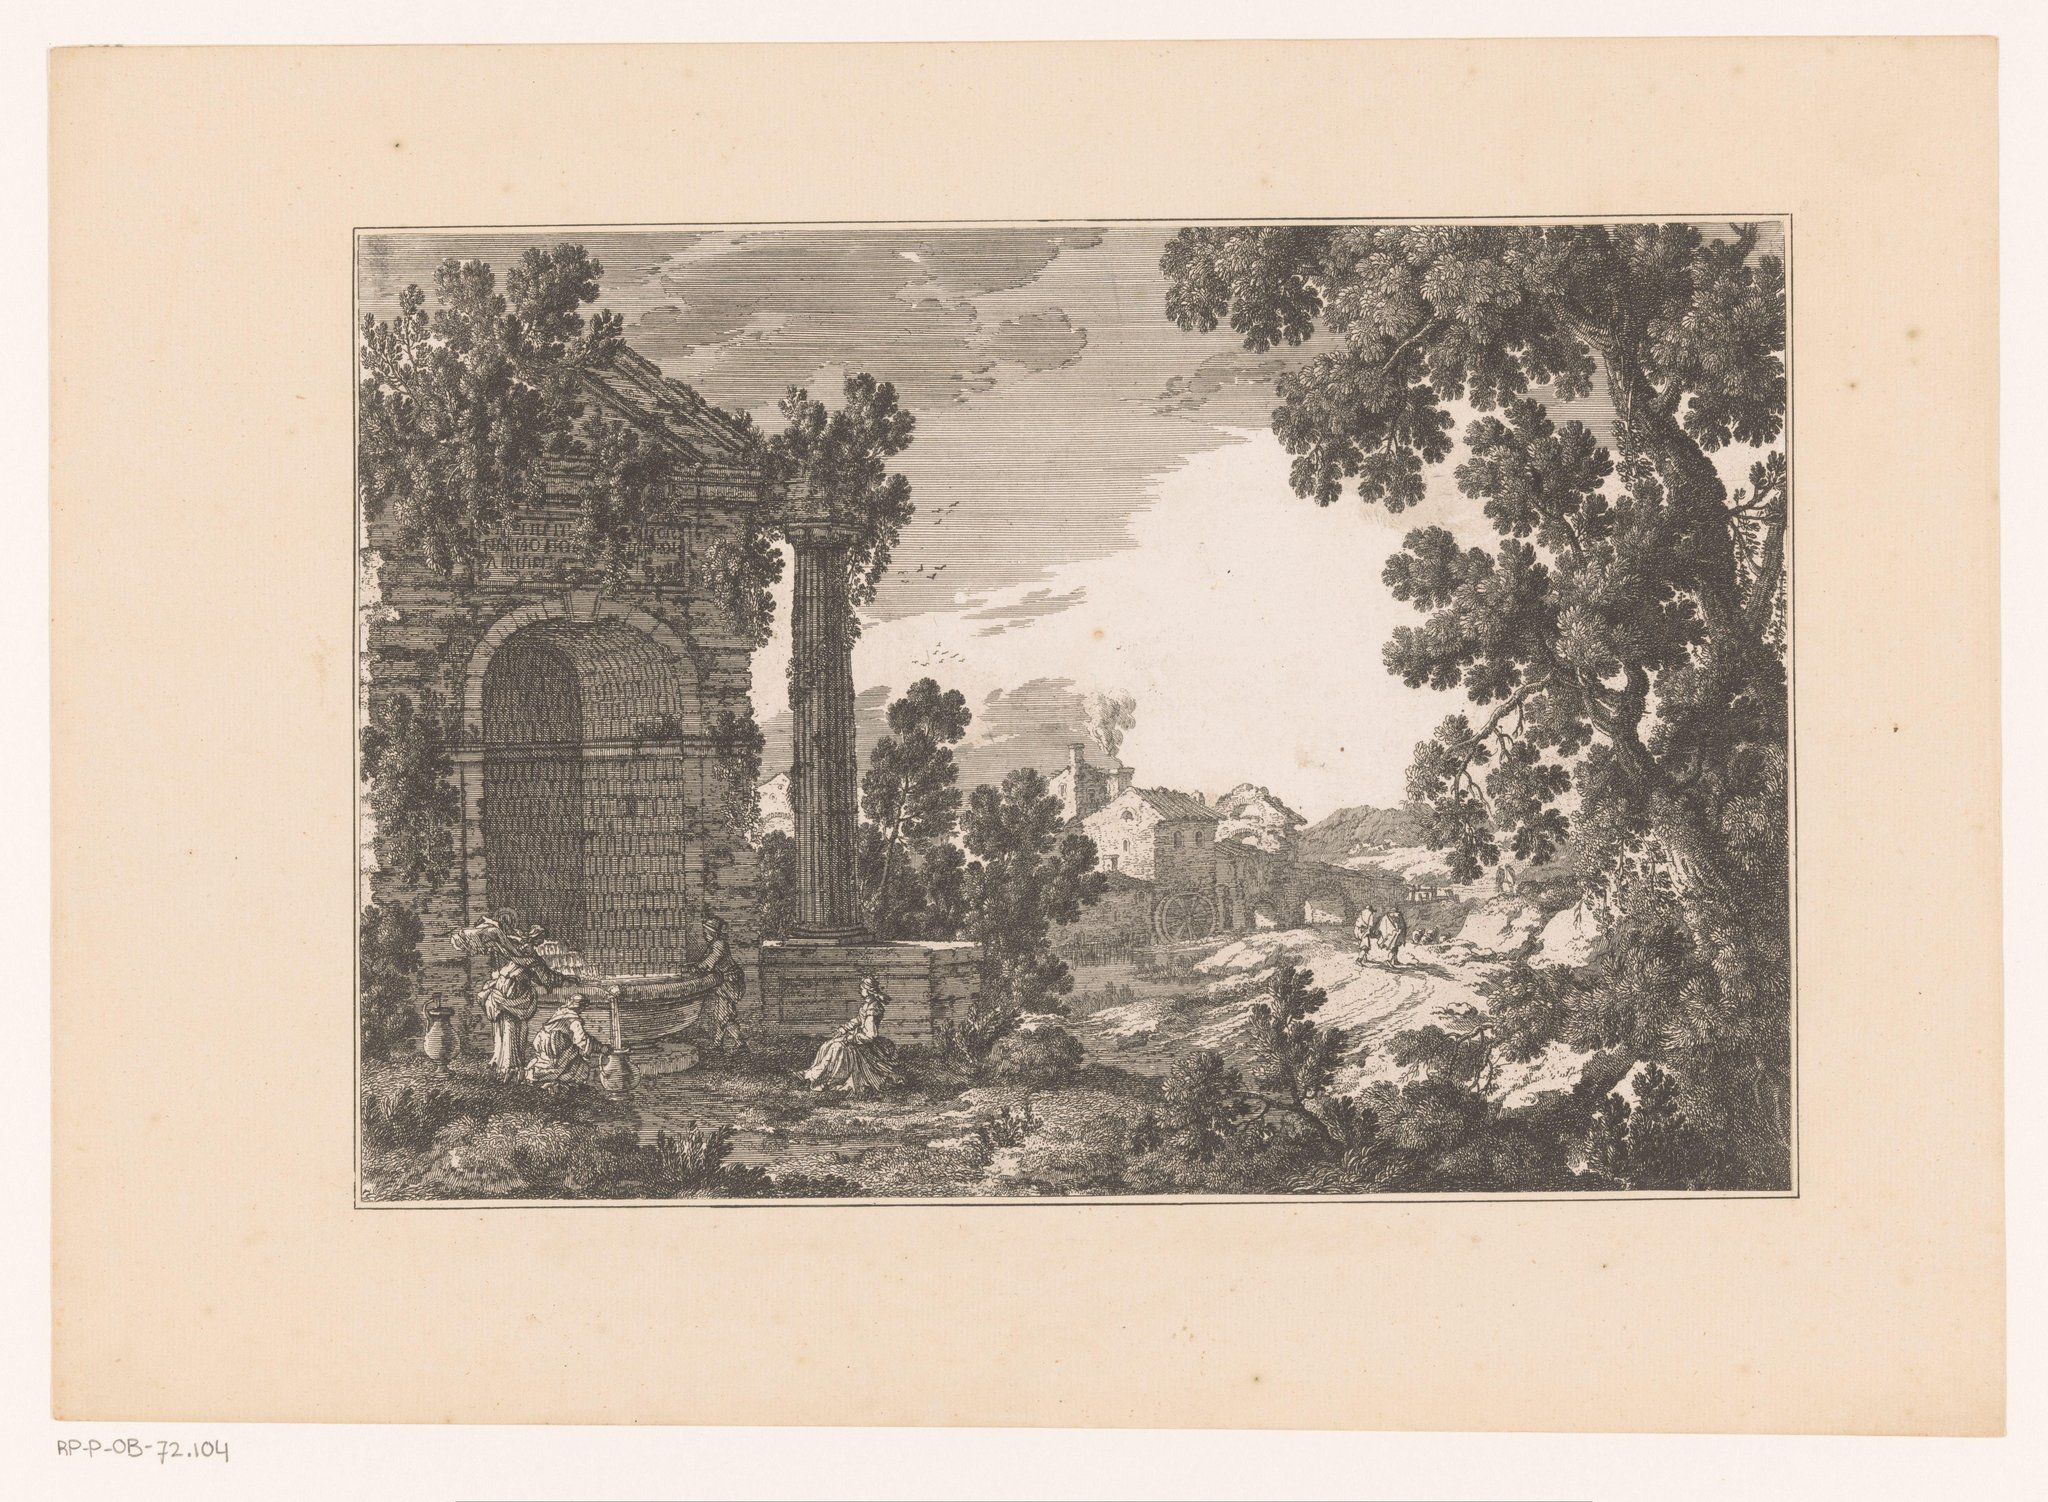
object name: print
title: Landschap met watermolen en antieke bron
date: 1613-1695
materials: paper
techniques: etching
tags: well, watermill in landscape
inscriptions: collector's mark: Lugt 240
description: Prenten met het signatuur 'Perelle' kunnen zowel door vader Gabriel als door zonen Nicolas en Adam gemaakt zijn.